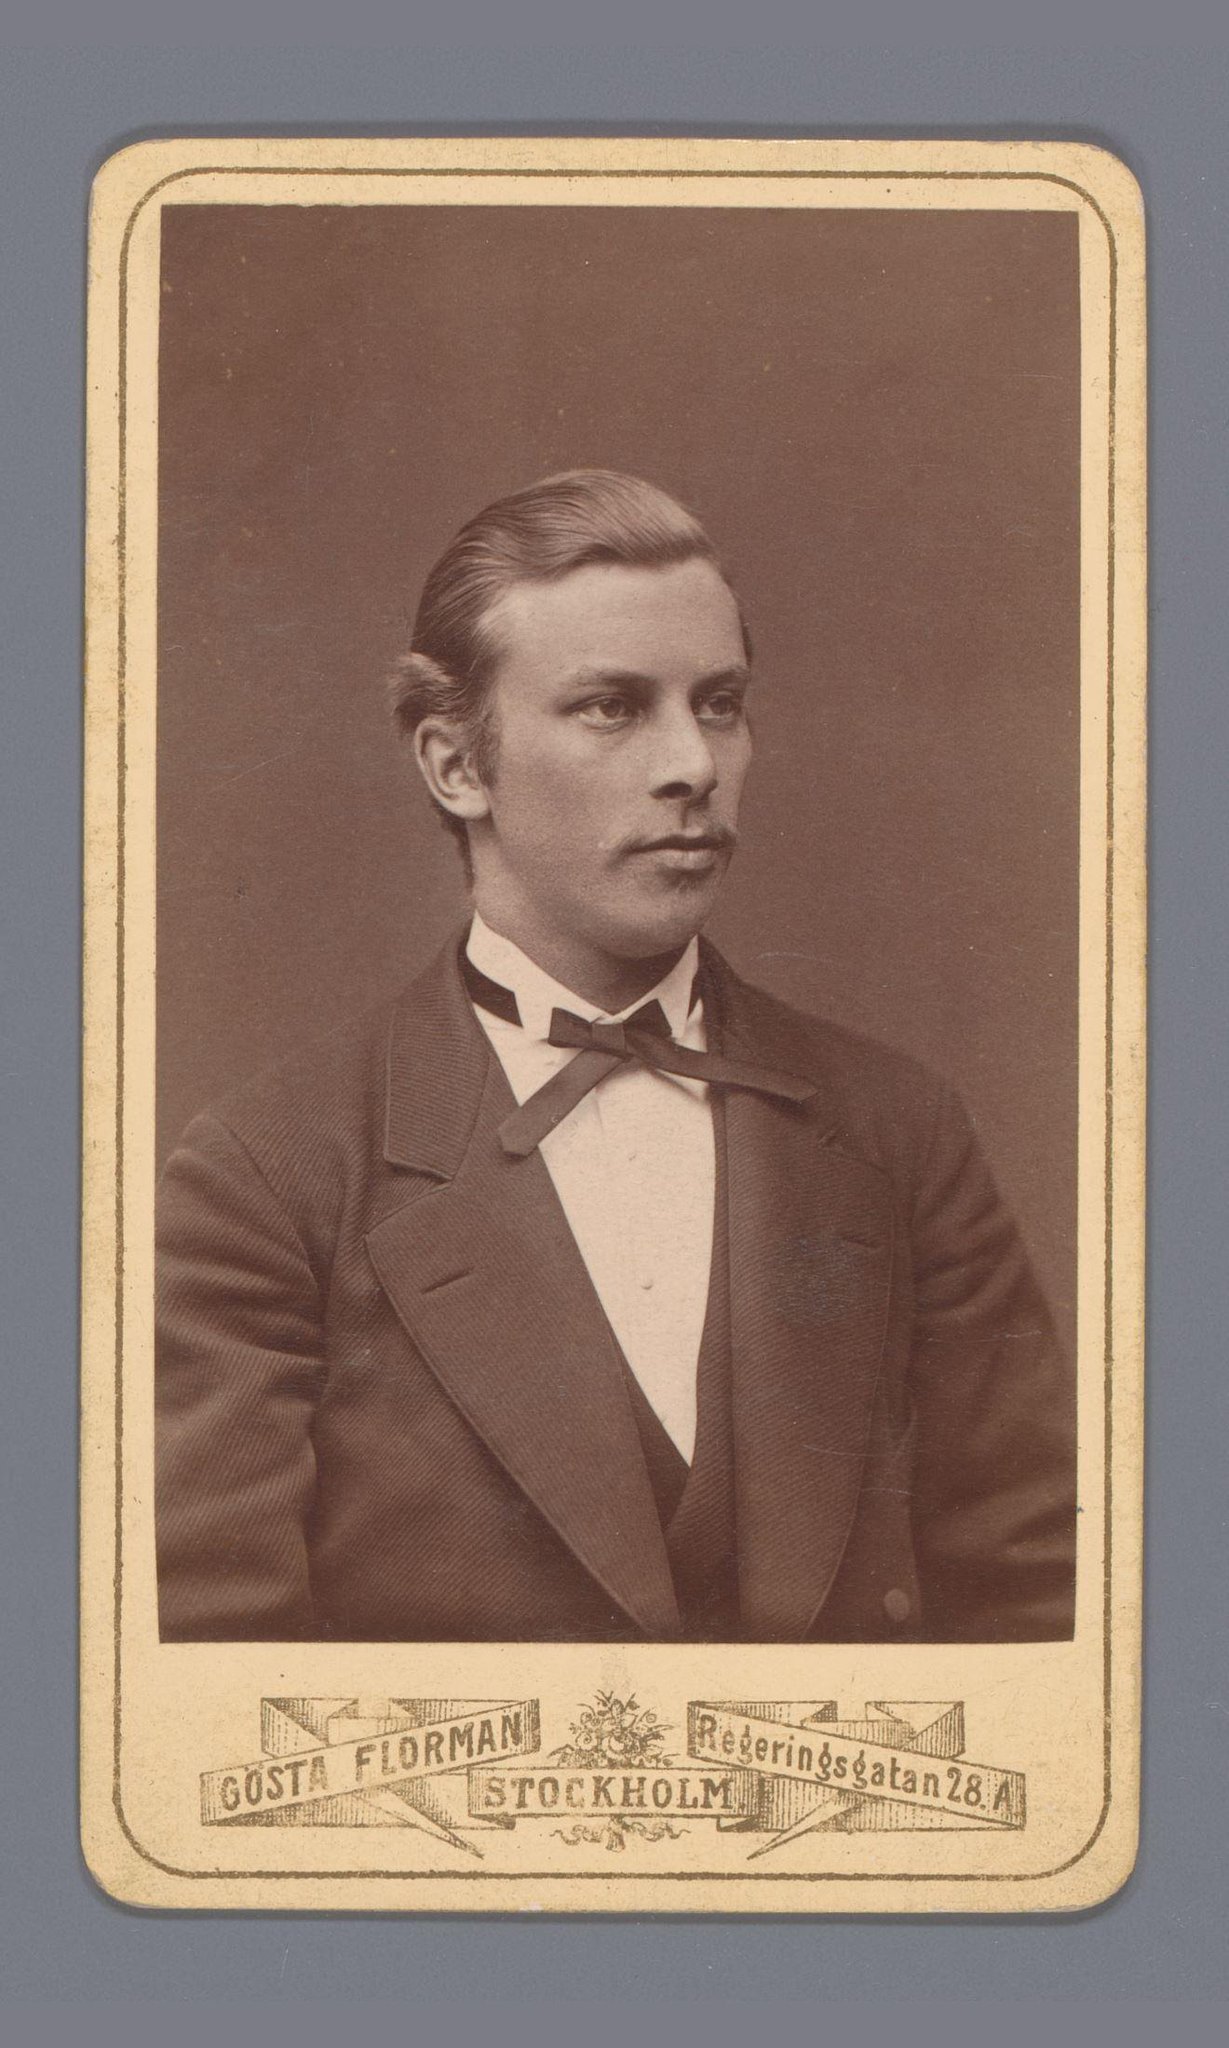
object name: carte de visite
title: Portret van een onbekende man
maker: gösta florman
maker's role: fotograaf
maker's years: 1831-1900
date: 1872-1880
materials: cardboard, paper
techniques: albumen print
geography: stockholm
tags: adult man, historical persons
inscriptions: address: ‘Regeringsgatan 28.A.’